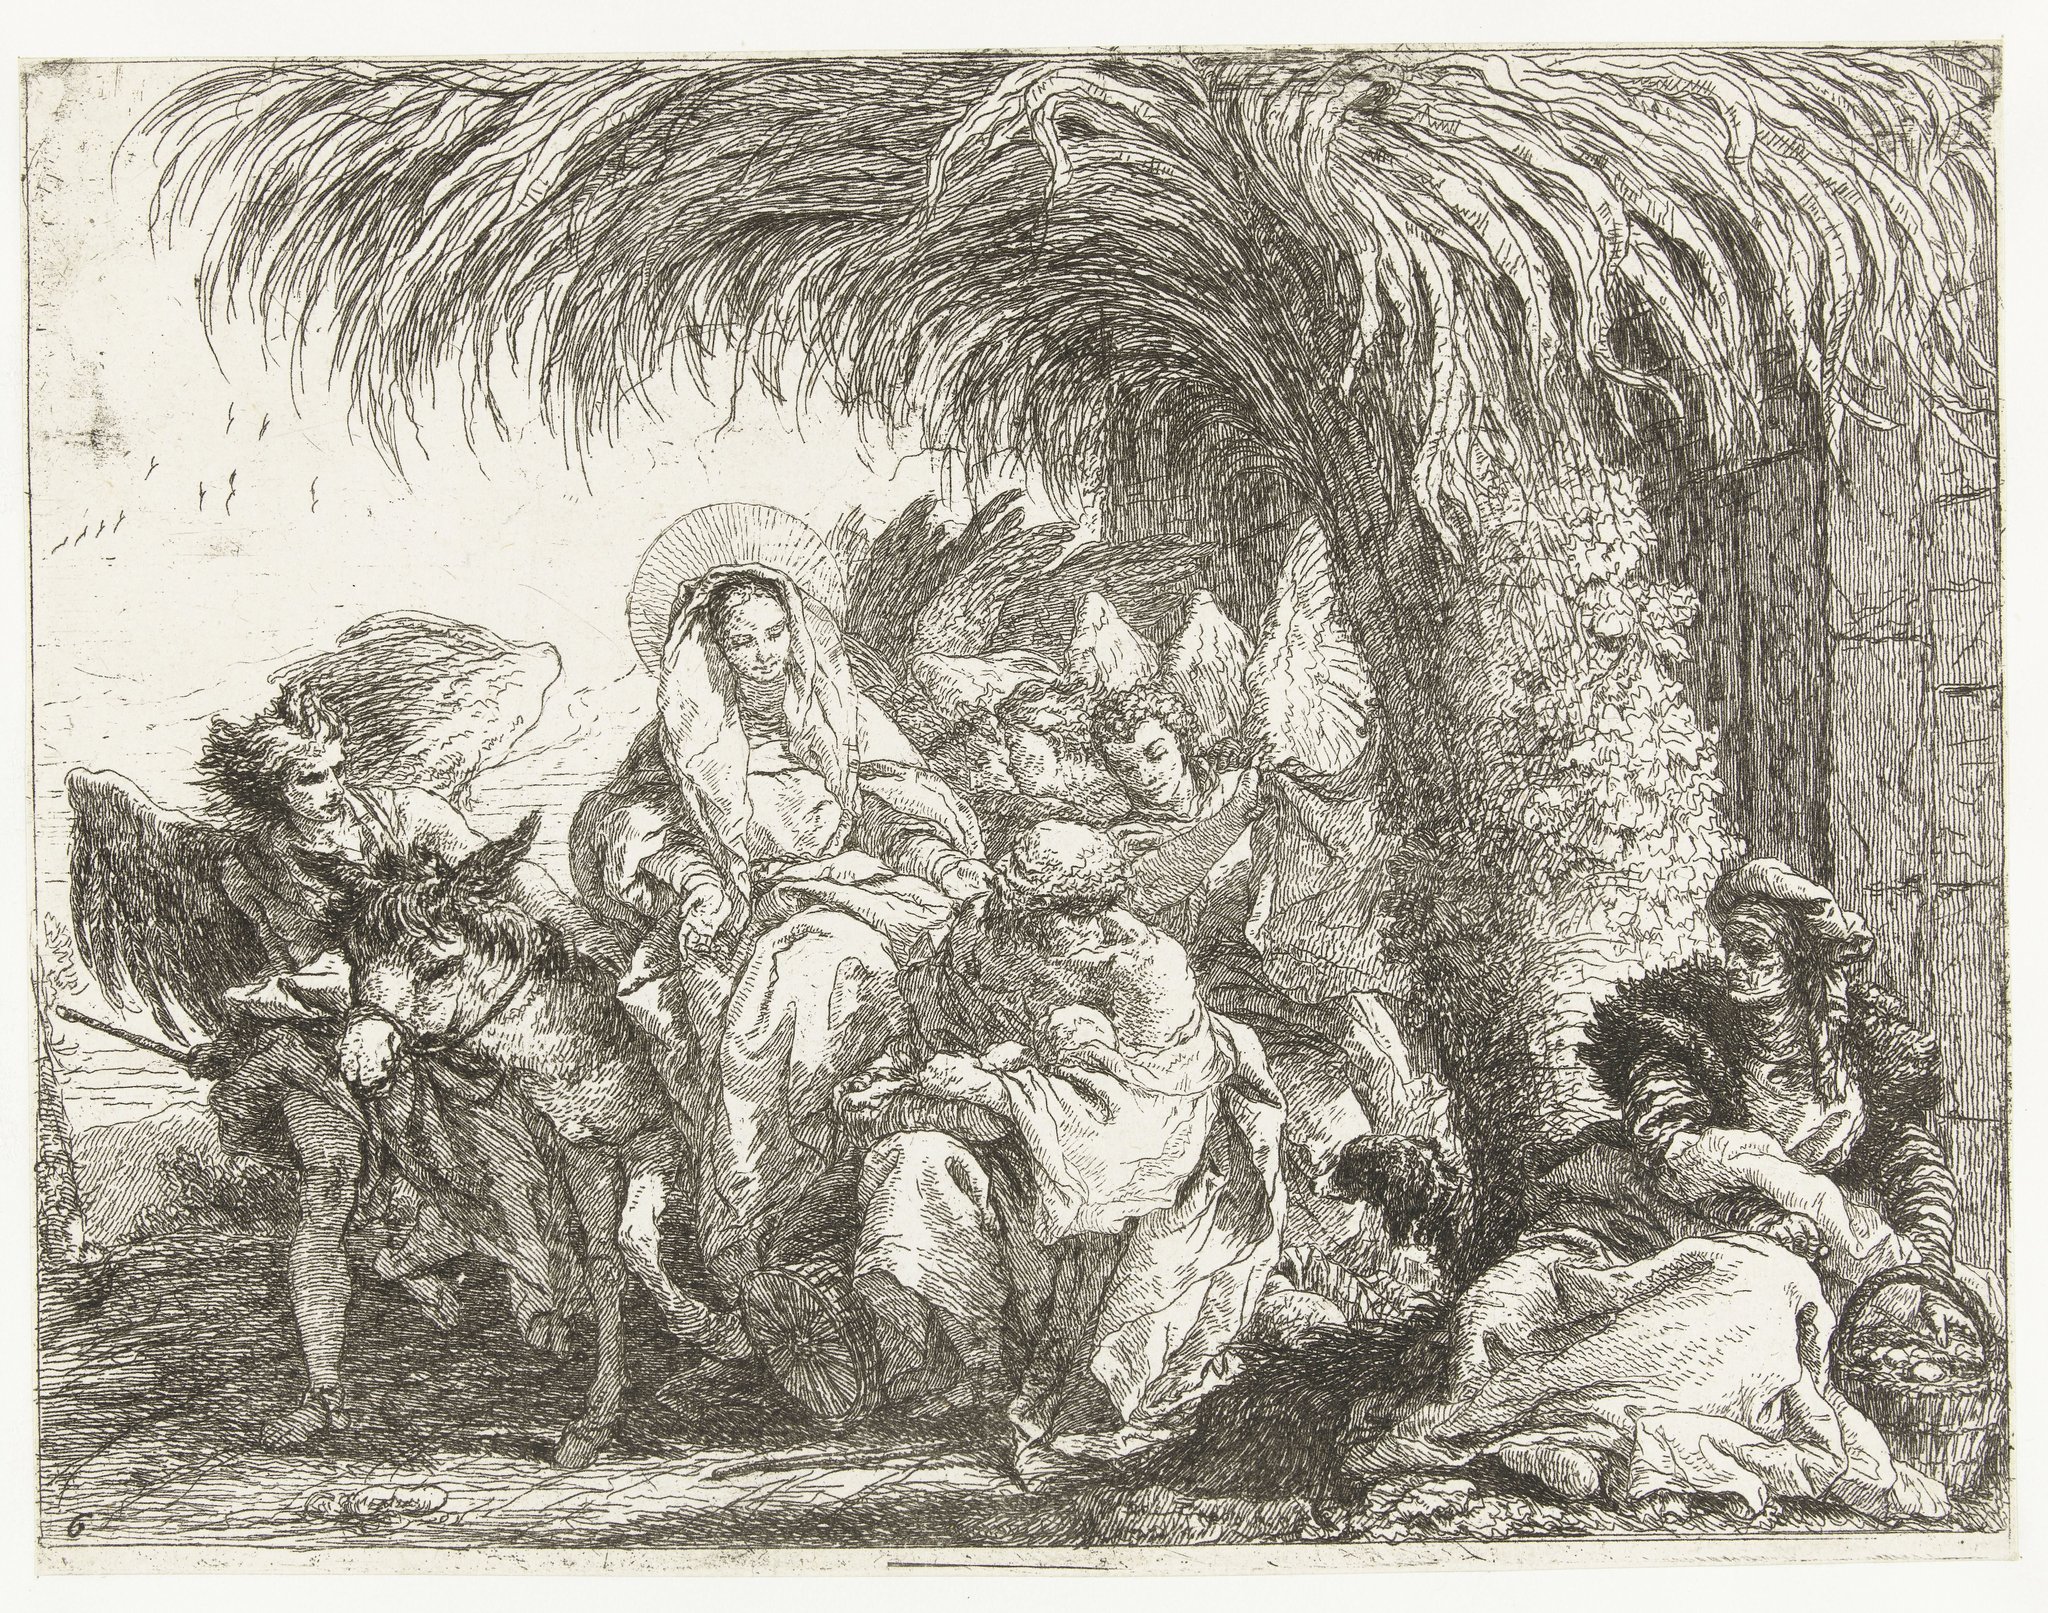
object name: print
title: Idee pittoresche sopra la Fugga in Egitto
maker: giovanni domenico tiepolo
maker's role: draughtsman, print maker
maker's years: 1727-1804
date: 1750-1753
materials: paper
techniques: etching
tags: rest on the flight into egypt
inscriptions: collector's mark: Lugt 2760, collector's mark: Lugt 2228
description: Prent uit serie van zevenentwintig prenten met de Vlucht naar Egypte.